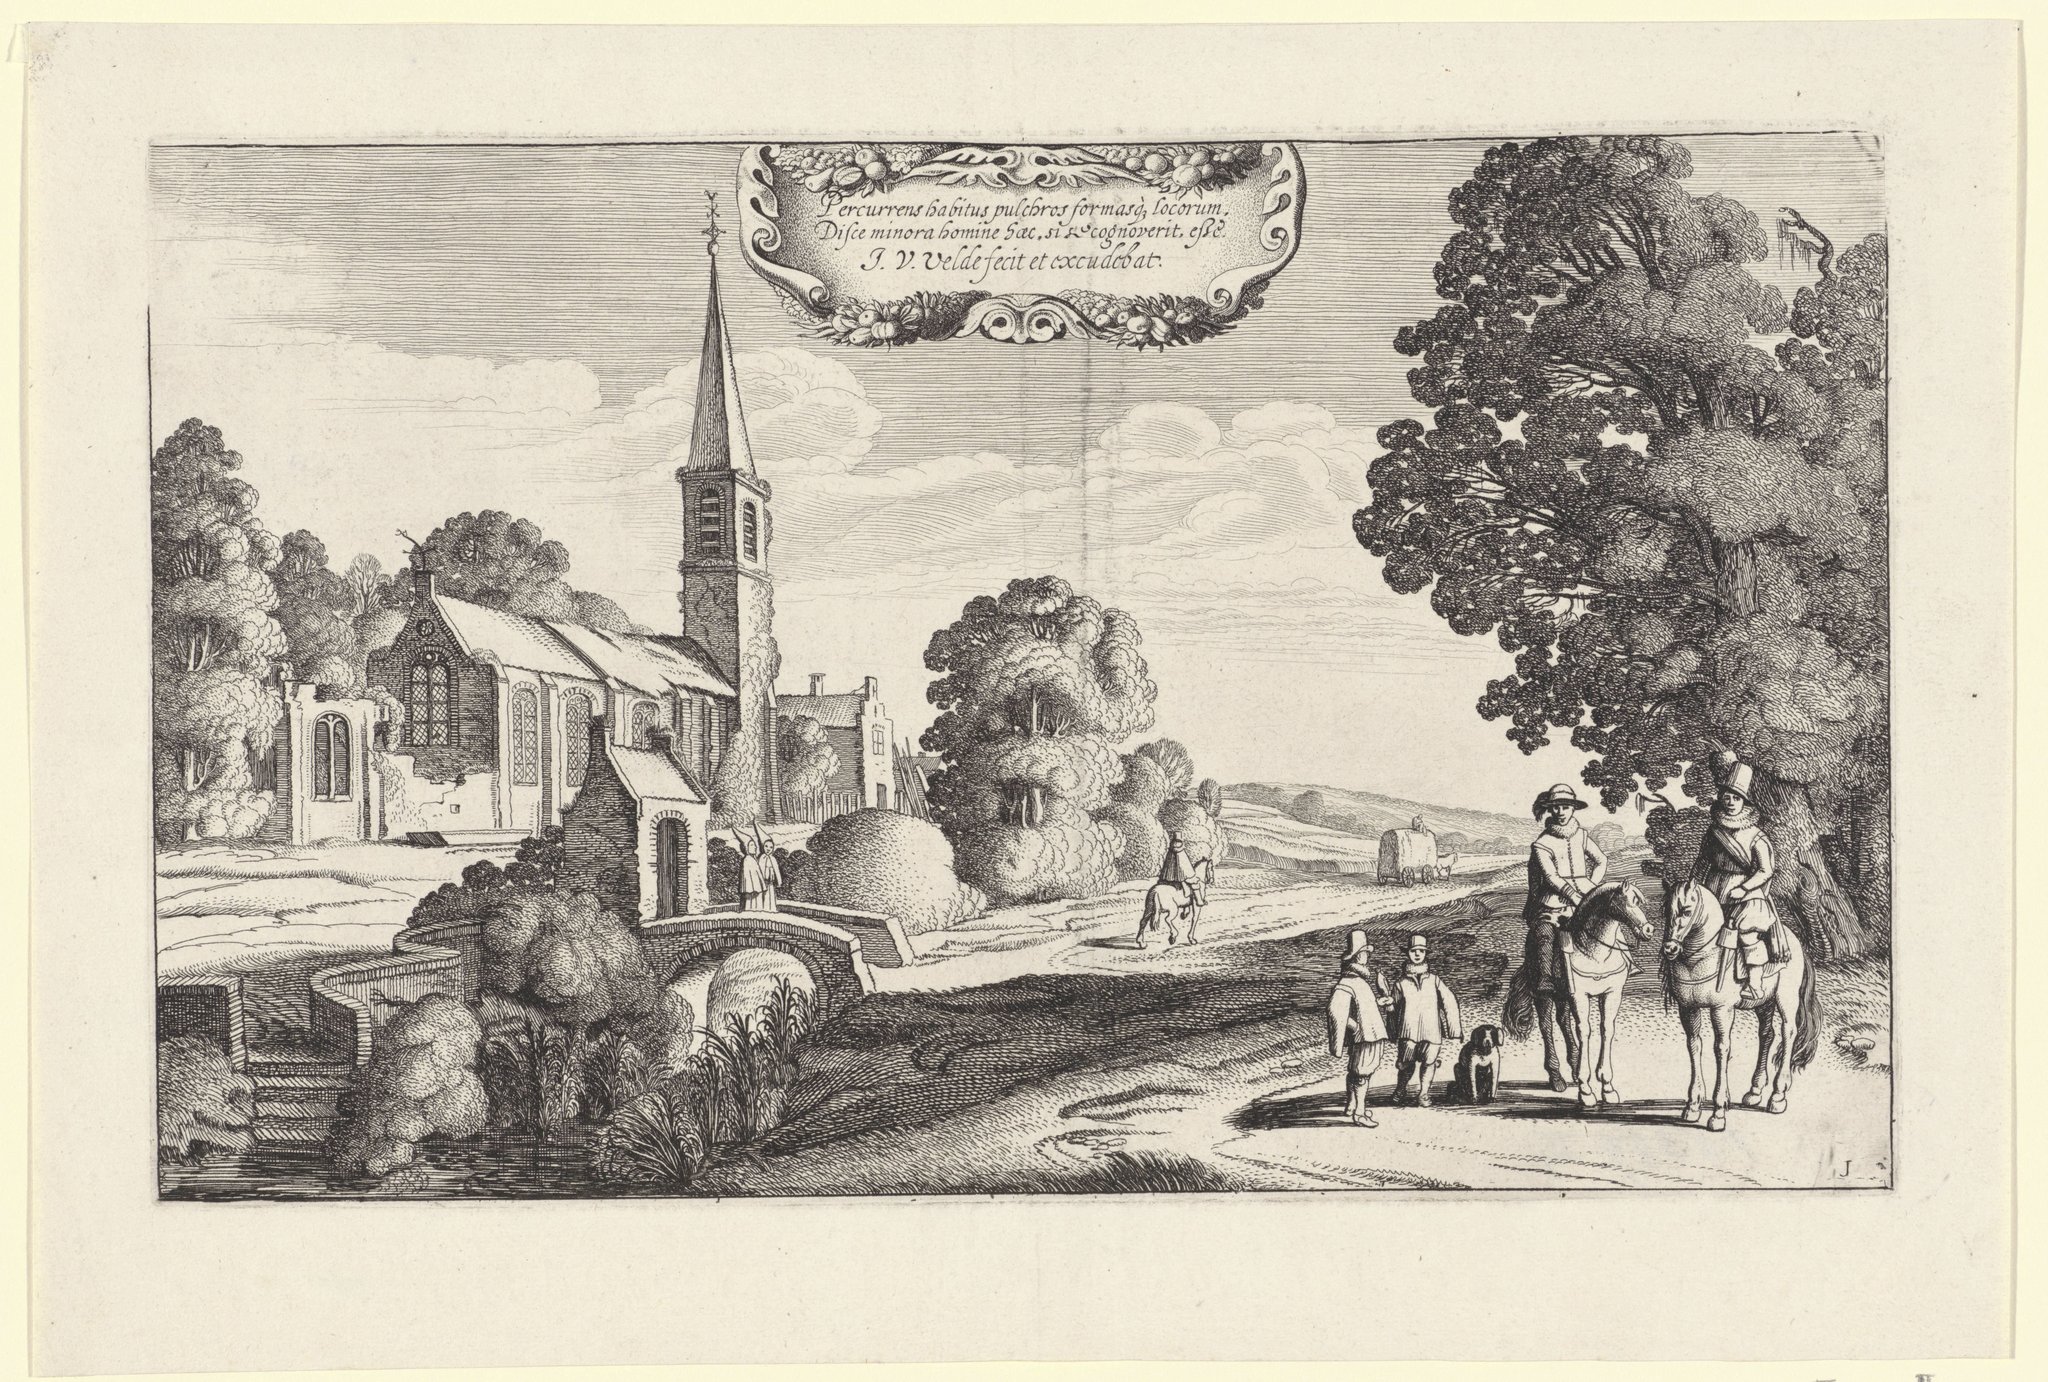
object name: print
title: Landweg langs een kerk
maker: jan van de velde (ii)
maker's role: draughtsman, painter, print maker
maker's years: 1593-1641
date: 1603-1641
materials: paper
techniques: etching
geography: northern netherlands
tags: riding a horse, ass, or mule; rider, horseman, sports, games ~ animals (+ hunting with falcon, hawk; falconry), church (exterior), road, path, hay-wagon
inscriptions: collector's mark: Lugt 240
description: Ruiters en twee valkeniersbedienden op een landweg langs een kerk. Op een brug met een poort twee geestelijken. In de verte op de landweg een hooiwagen. Titelprent van een serie van vier.